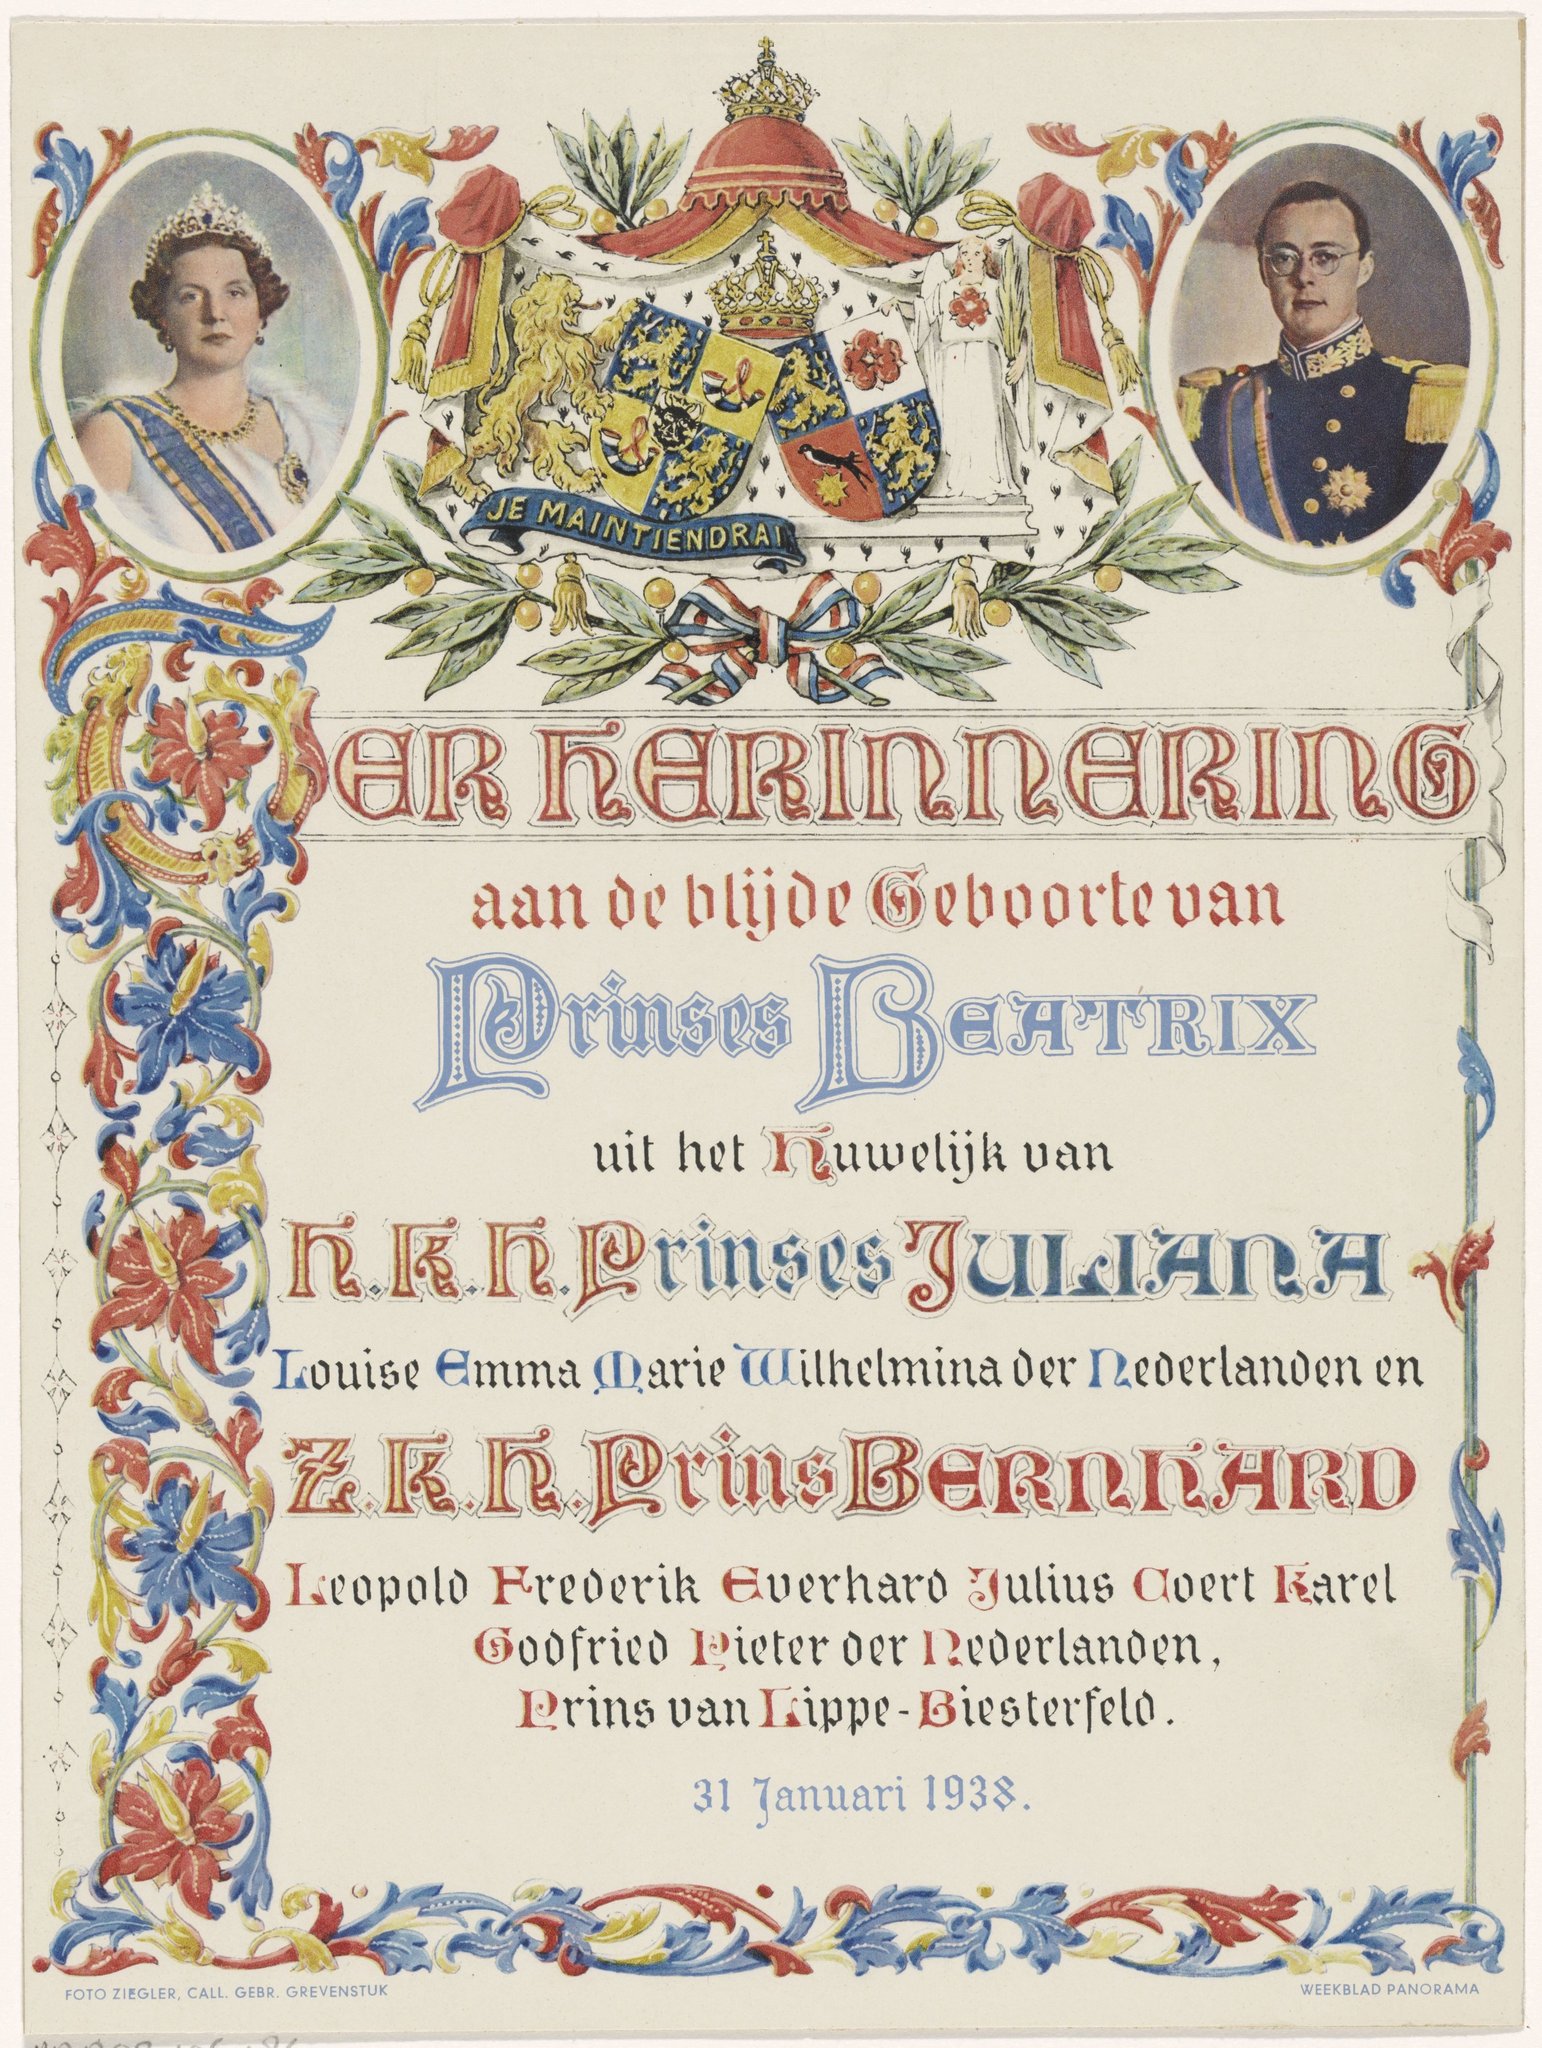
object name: photomechanical print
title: Feestplaat ter ere van de geboorte van Beatrix, koningin der Nederlanden, op 31 januari 1938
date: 1938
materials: paper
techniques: rotogravure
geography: netherlands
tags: utrecht, bernhard (prins der nederlanden), beatrix (koningin der nederlanden), the hague, juliana of the netherlands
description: Feestplaat ter ere van de geboorte van Beatrix op 31 januari 1938. In het midden elf regels Nederlandse tekst. Midden boven twee wapens met een leeuw en portretten van Juliana en Bernhard, elk in een ovaal. Geheel in een geornamenteerde omlijsting. Pagina uit 'Weekblad Panorama'.